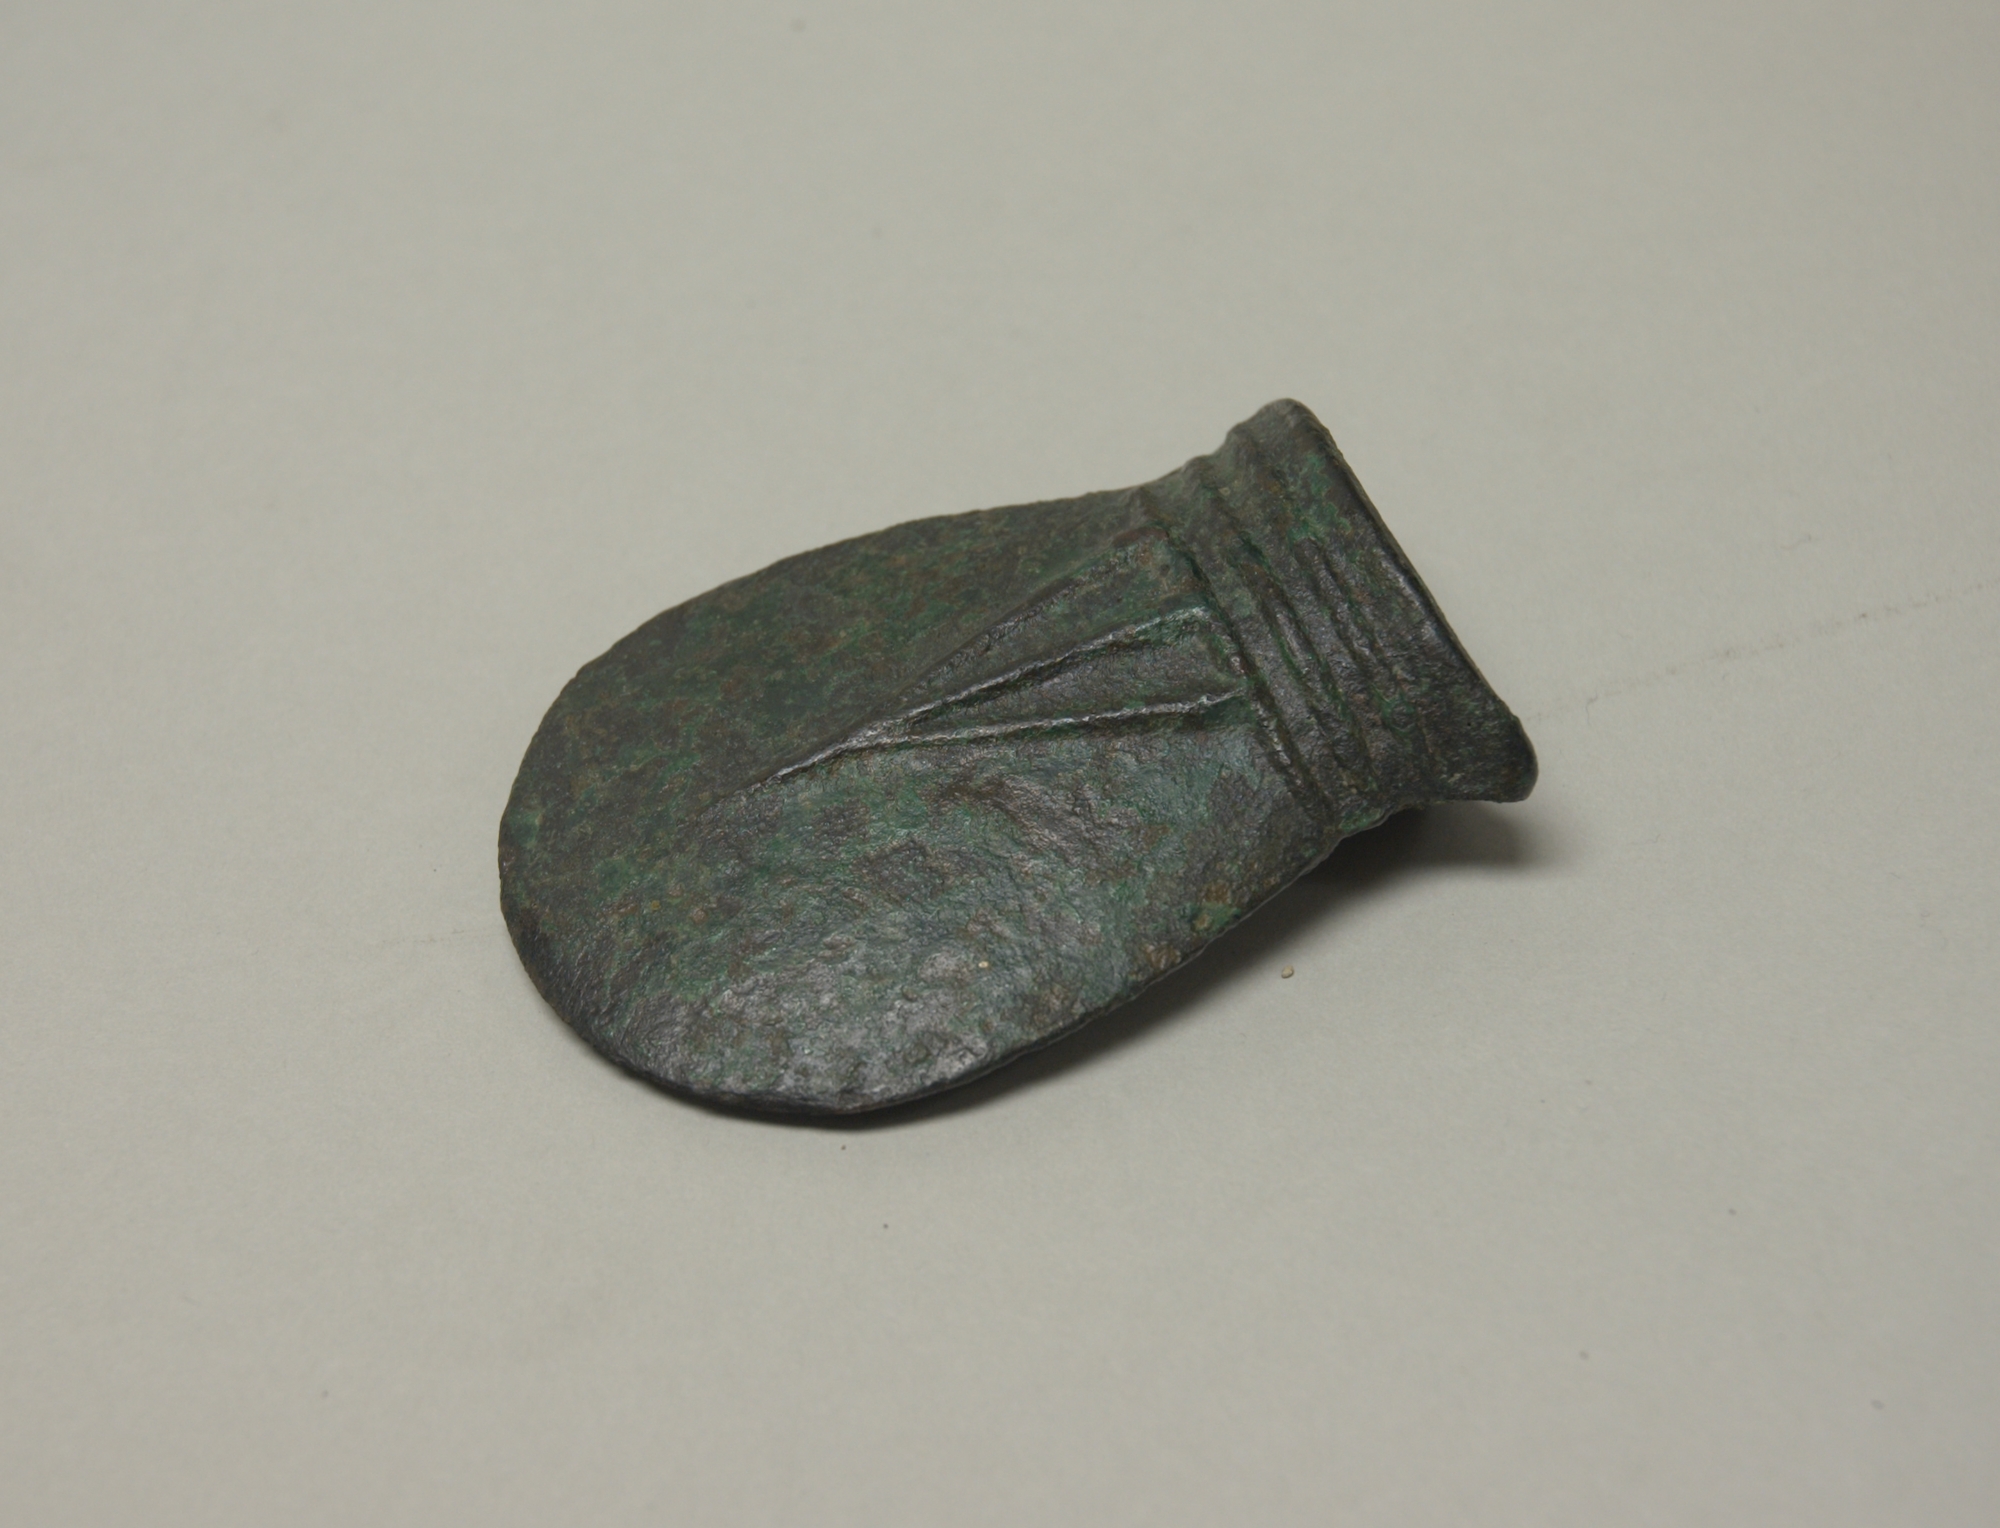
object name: hafted ax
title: Hafted Ax (type 9a)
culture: indonesian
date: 500 BCE-300 CE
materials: bronze